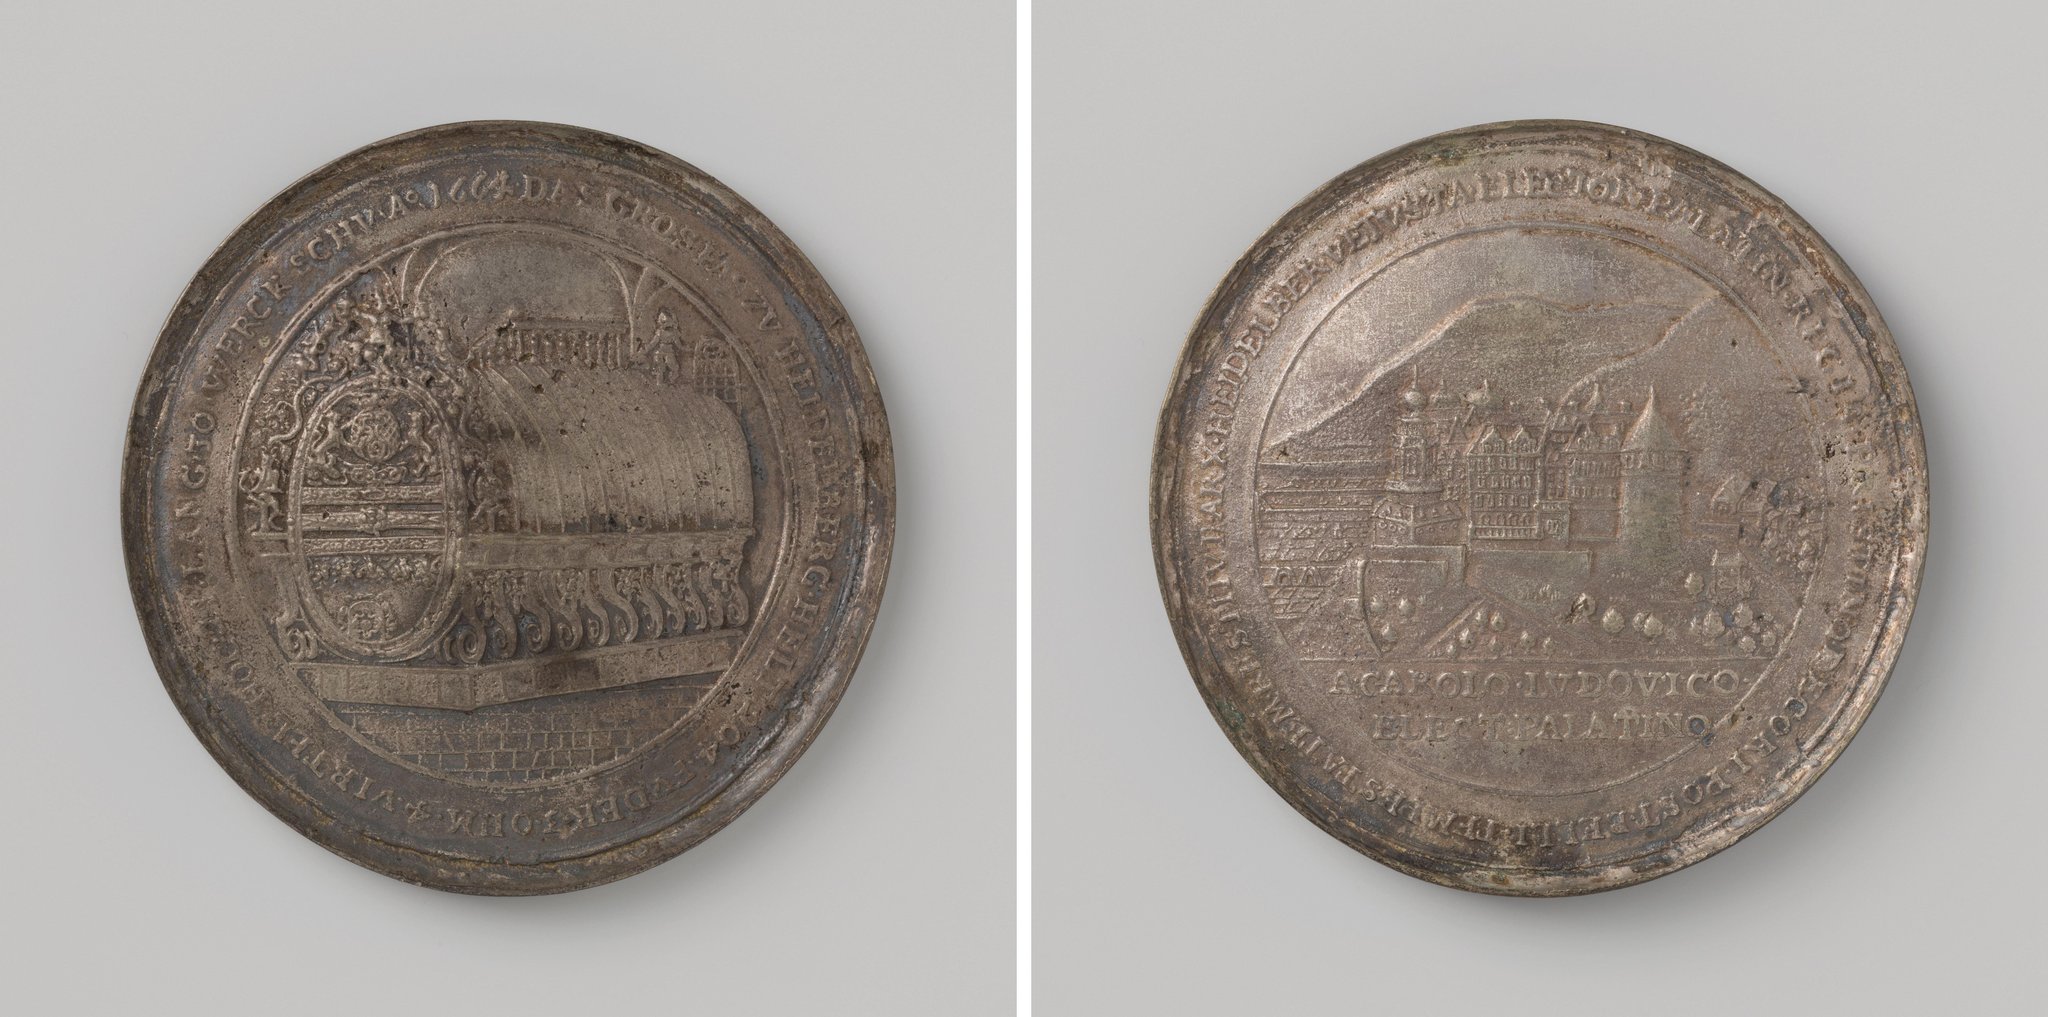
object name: history medal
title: Grote vat van Heidelberg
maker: Anonymous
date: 1664-1688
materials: silver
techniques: striking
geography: germany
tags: wine-vault, 'cave', wooden container: barrel, cask, bucket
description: Zilveren penning. Voorzijde: het Grote Heidelberger Vat binnen omschrift. Keerzijde: slot boven opschrift, binnen omschrift.